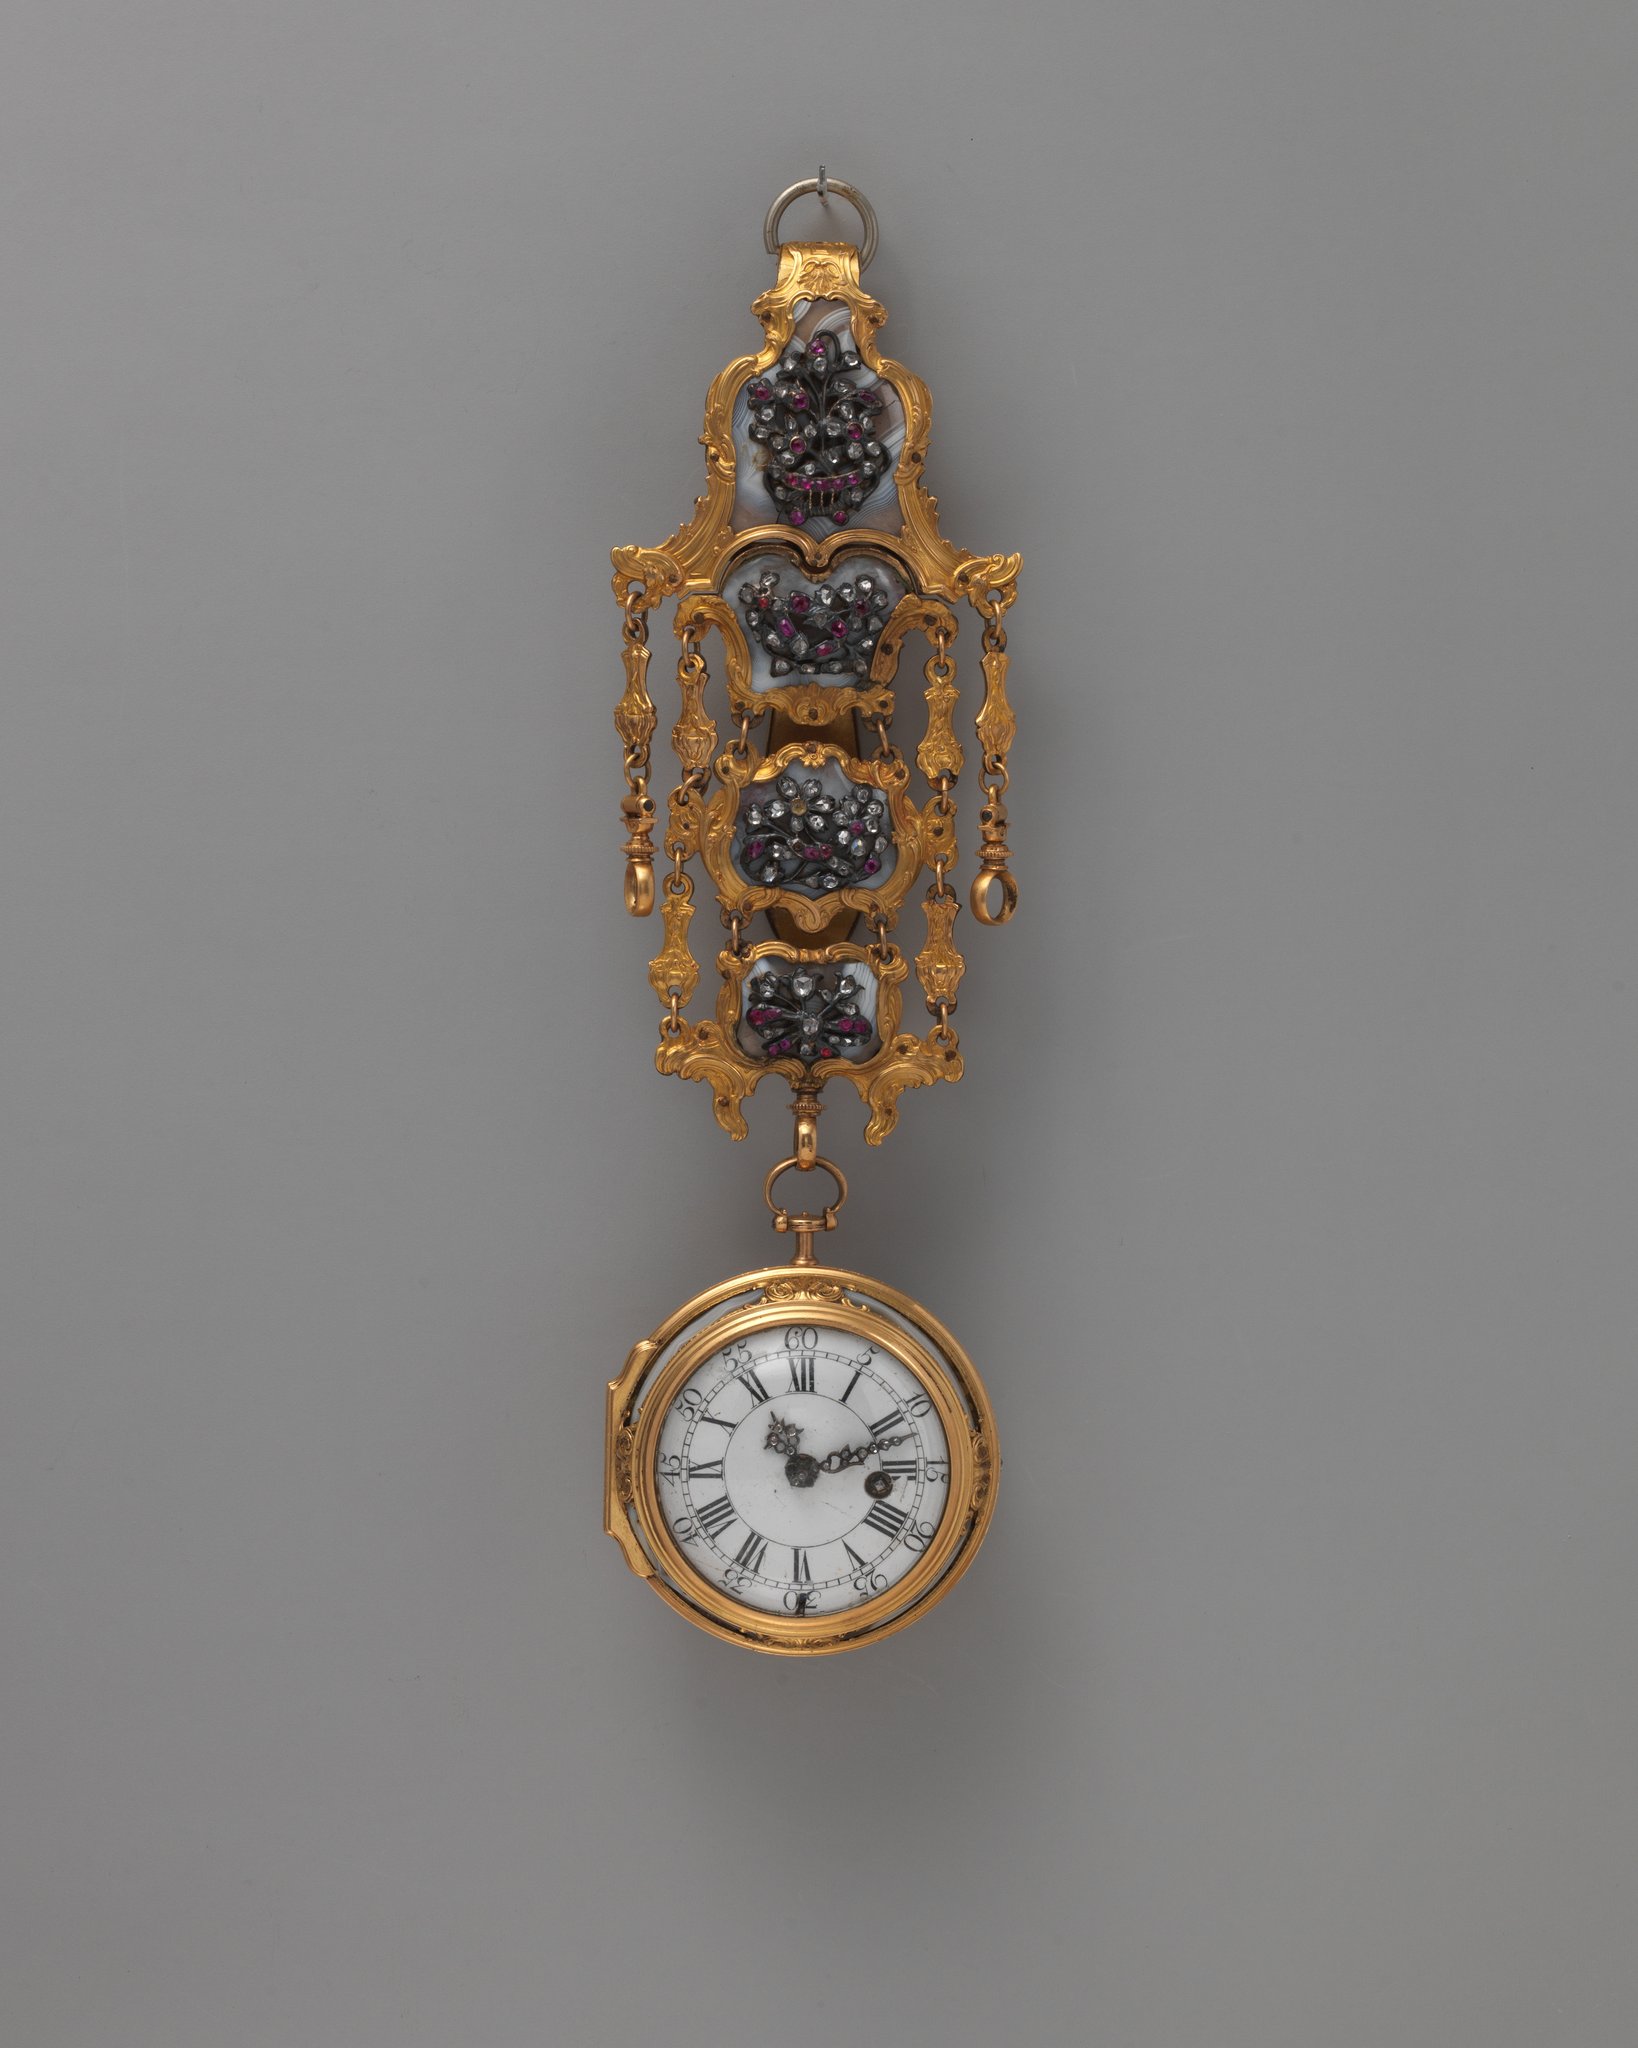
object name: watch and chatelaine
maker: john rich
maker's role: maker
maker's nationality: british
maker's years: 1735-1775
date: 1740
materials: stone, diamond, enamel, gold, gemstone